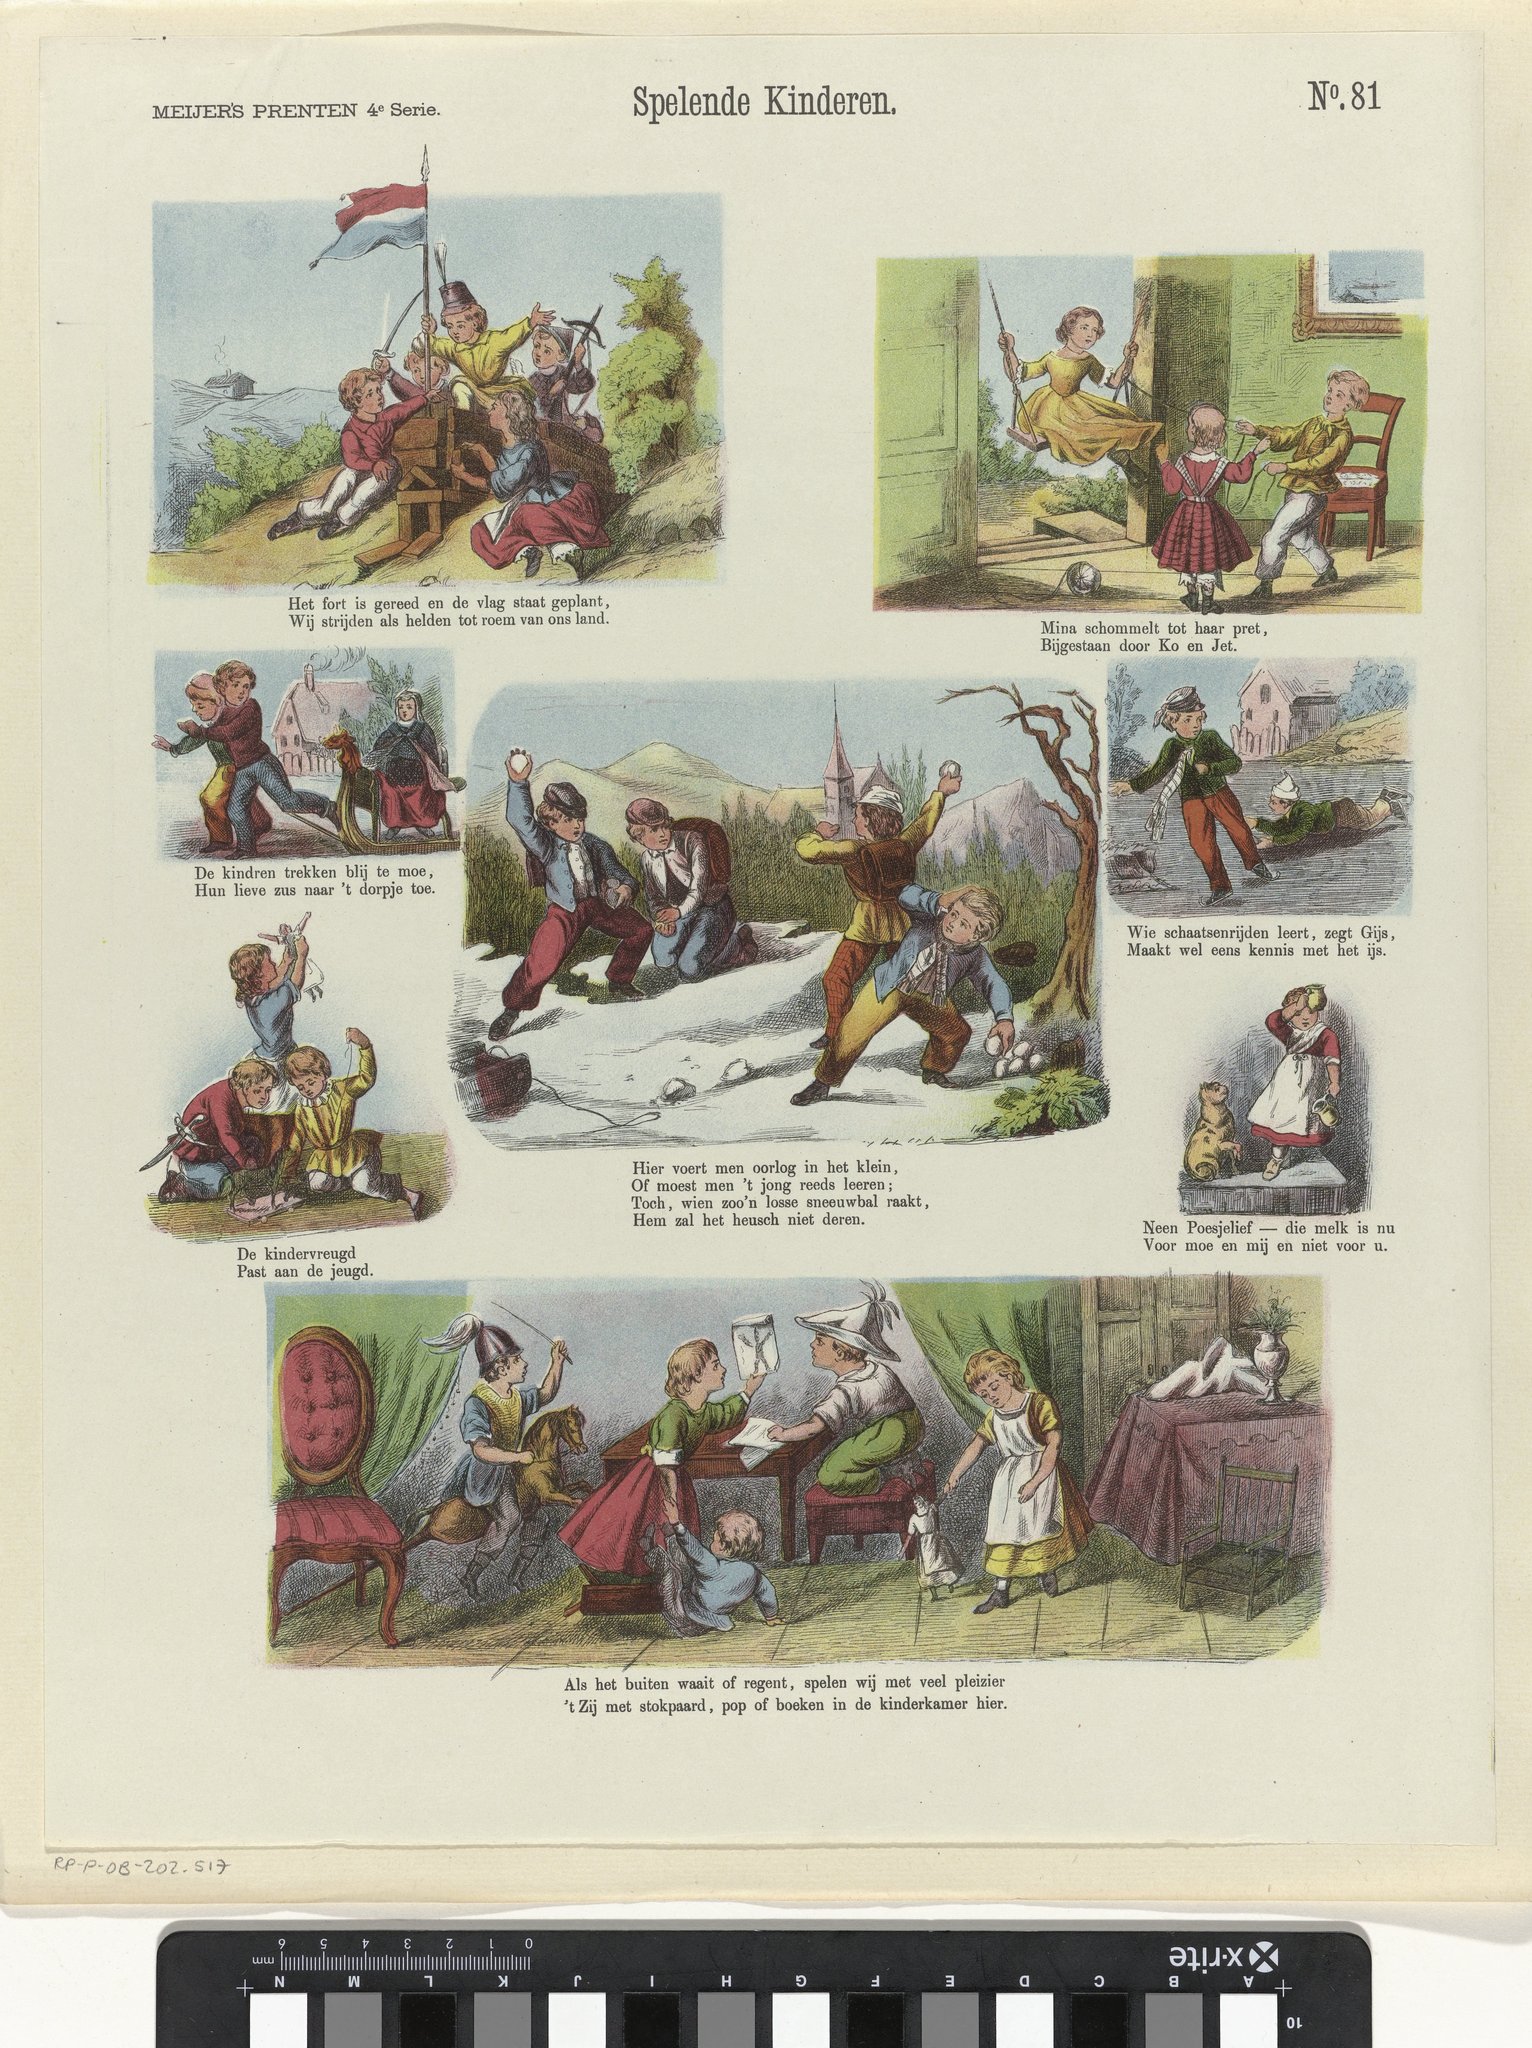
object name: print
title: Spelende kinderen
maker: Anonymous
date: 1881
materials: paper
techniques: lithograph, letterpress printing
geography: amsterdam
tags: children's games and plays, (playing with) dolls, swinging (children's game), throwing snowballs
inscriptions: collector's mark: Lugt 2760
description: Blad met 8 voorstellingen over spelende kinderen, onder anderen kinderen die schommelen, sneeuwballen gooien en een fort bouwen. Onder elke afbeelding een twee- of vierregelig vers. Genummerd rechtsboven: No. 81.